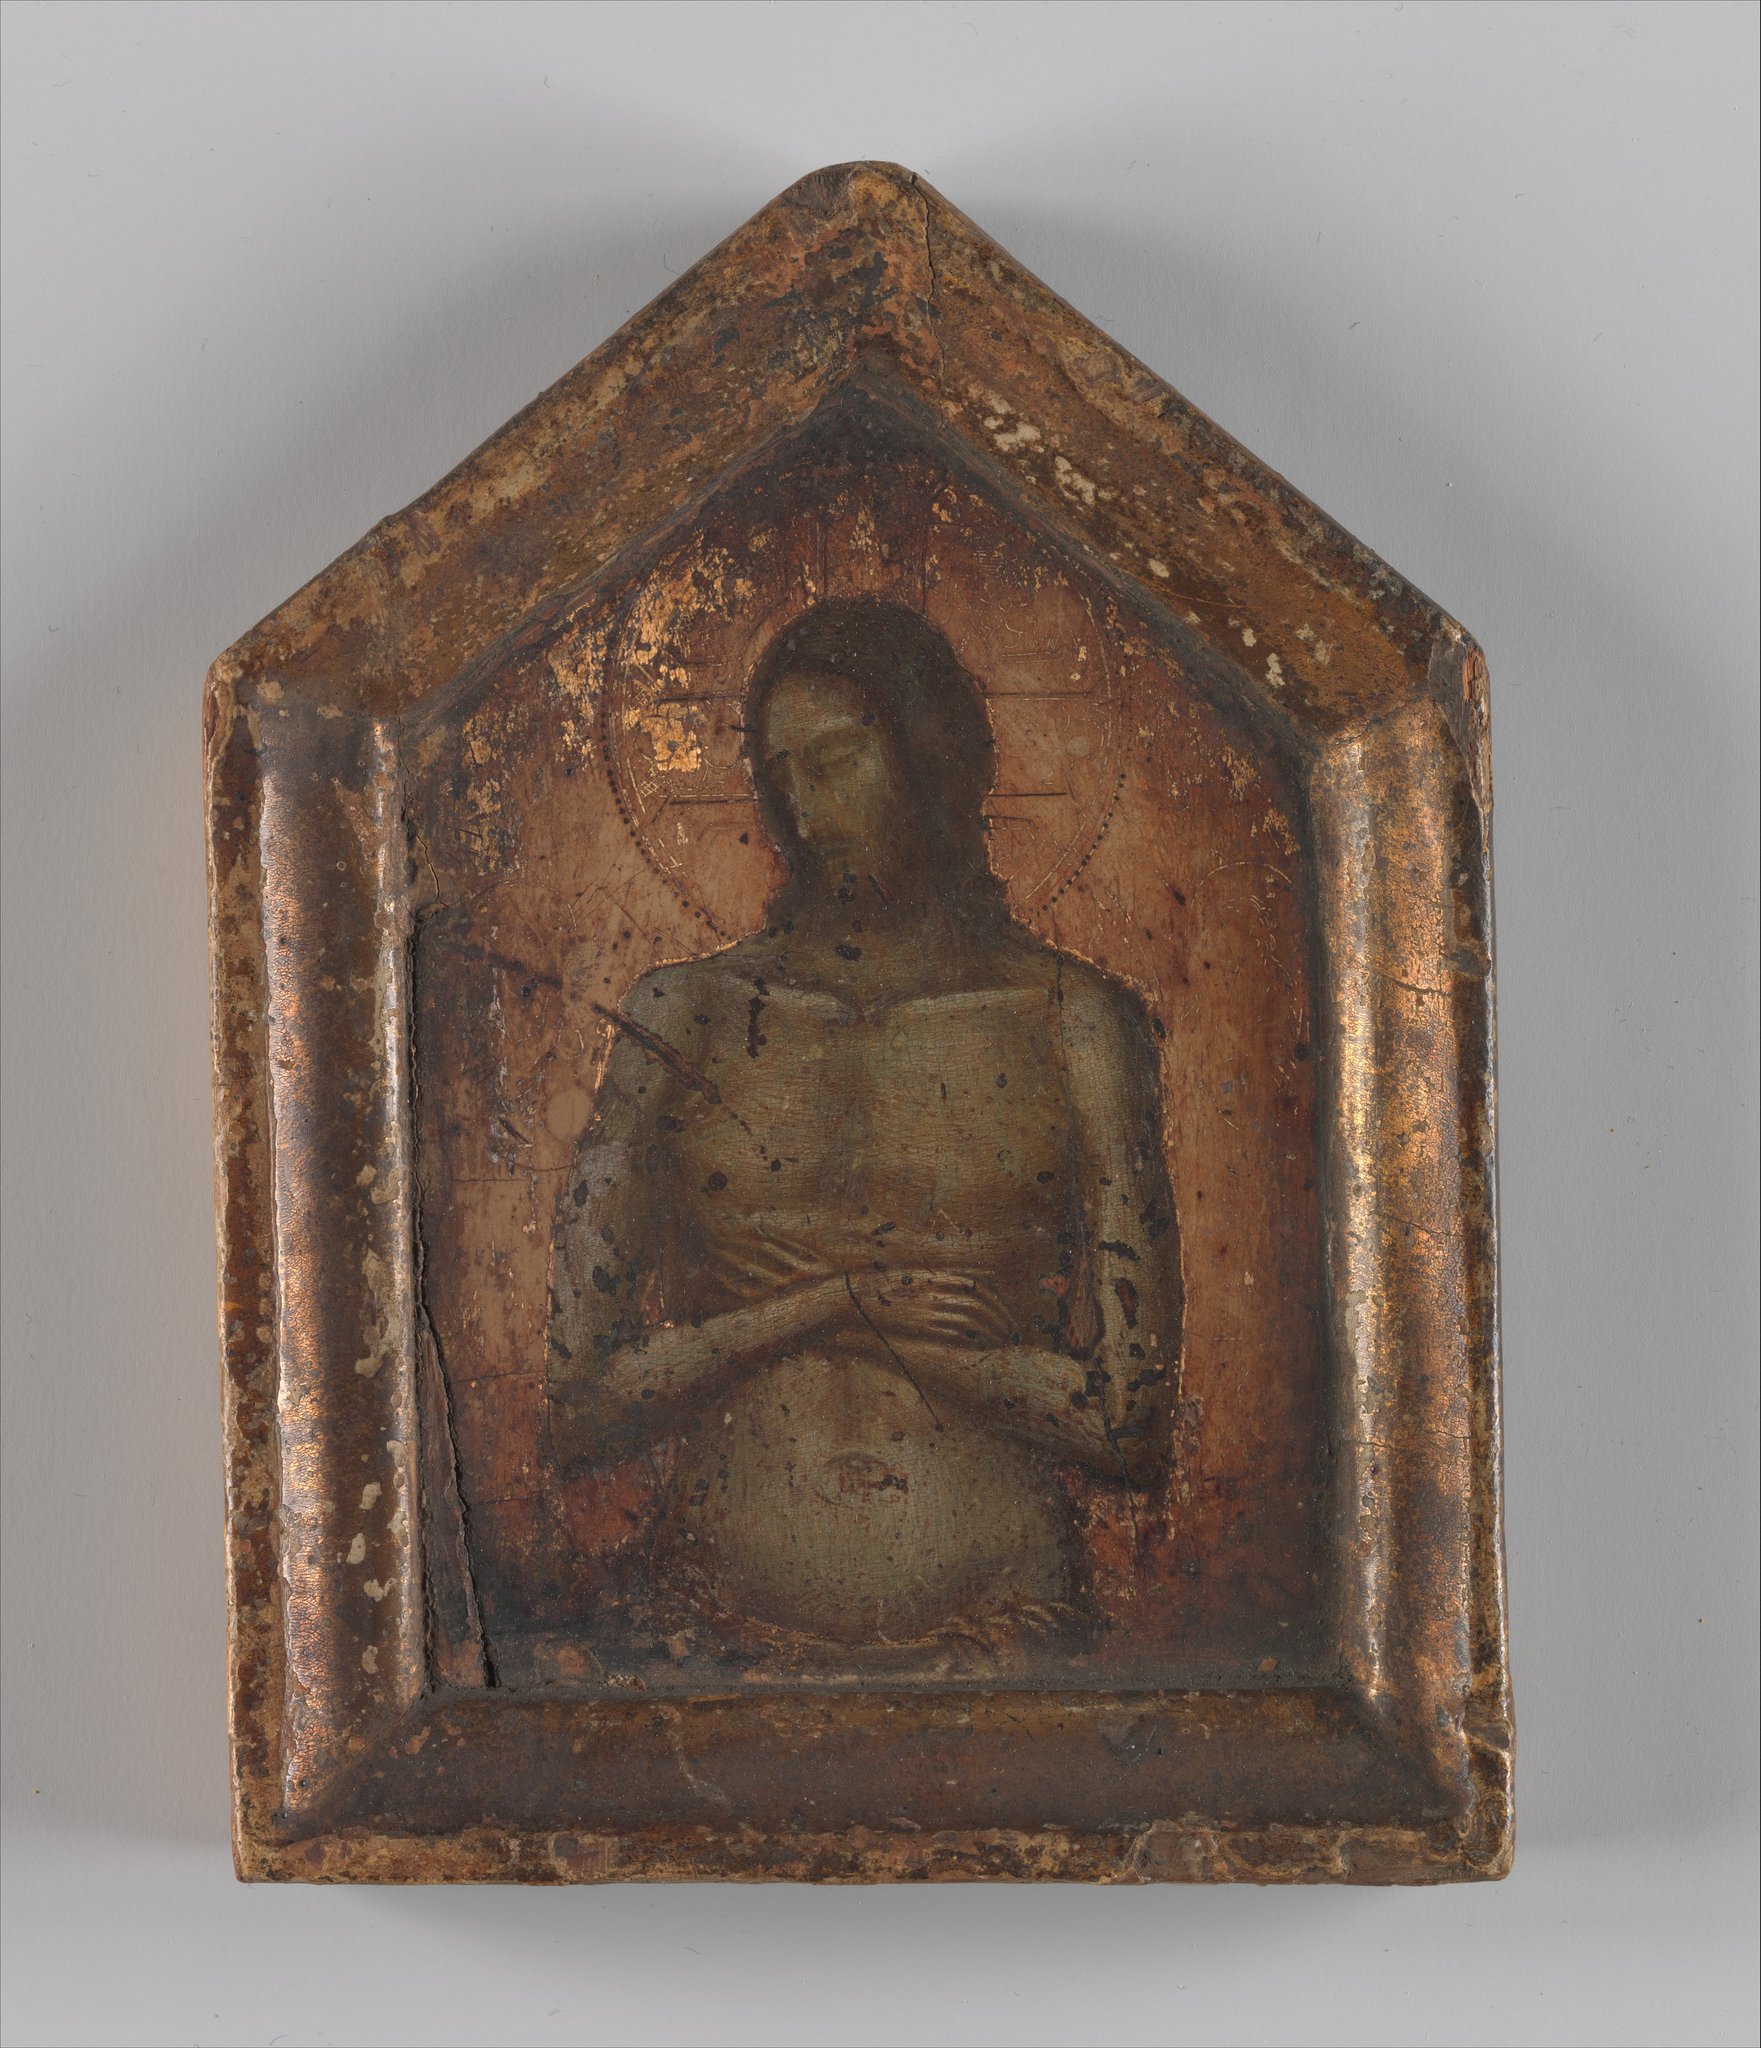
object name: frame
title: Engaged diptych moldings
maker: tuscany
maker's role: artist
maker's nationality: tuscany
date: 1300-1325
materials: wood